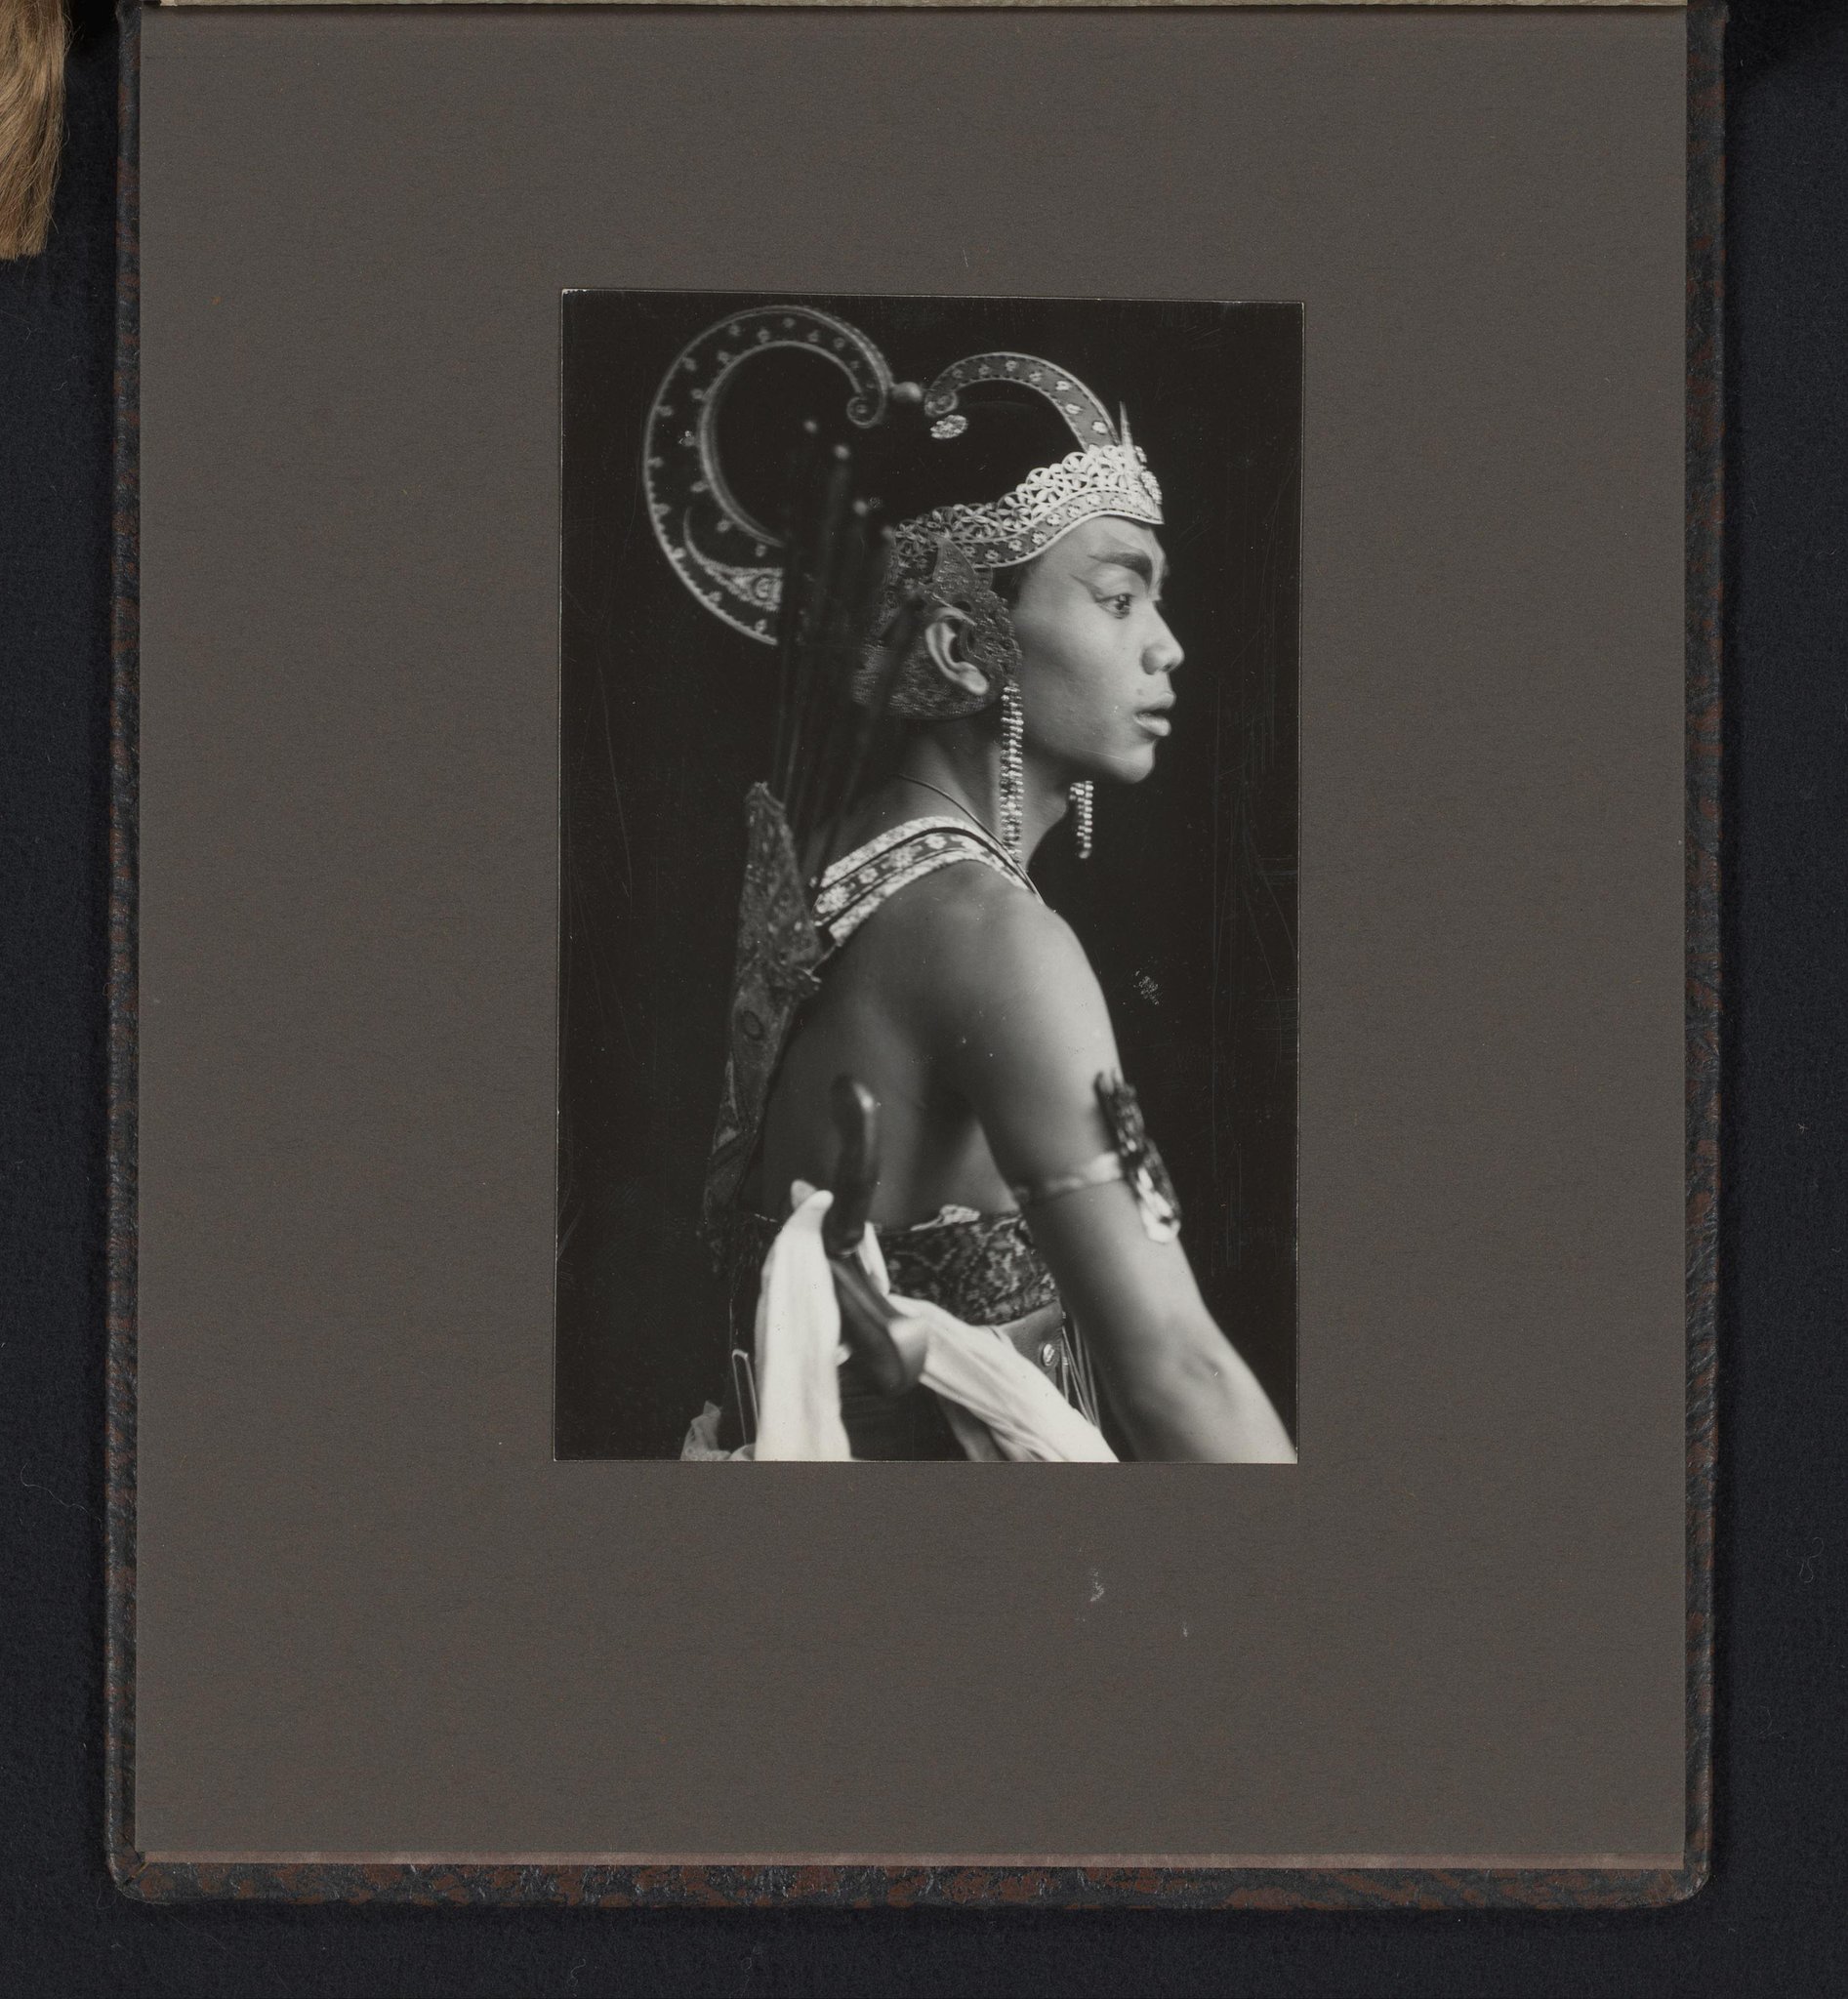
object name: album leaf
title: Portret van een Javaanse danseres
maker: adeline andrea. du celliée muller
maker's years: 1899-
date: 1930-1940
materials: paper, photographic support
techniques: gelatin silver print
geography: dutch east indies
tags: adult man, portrait of dancer, dutch east indies, the